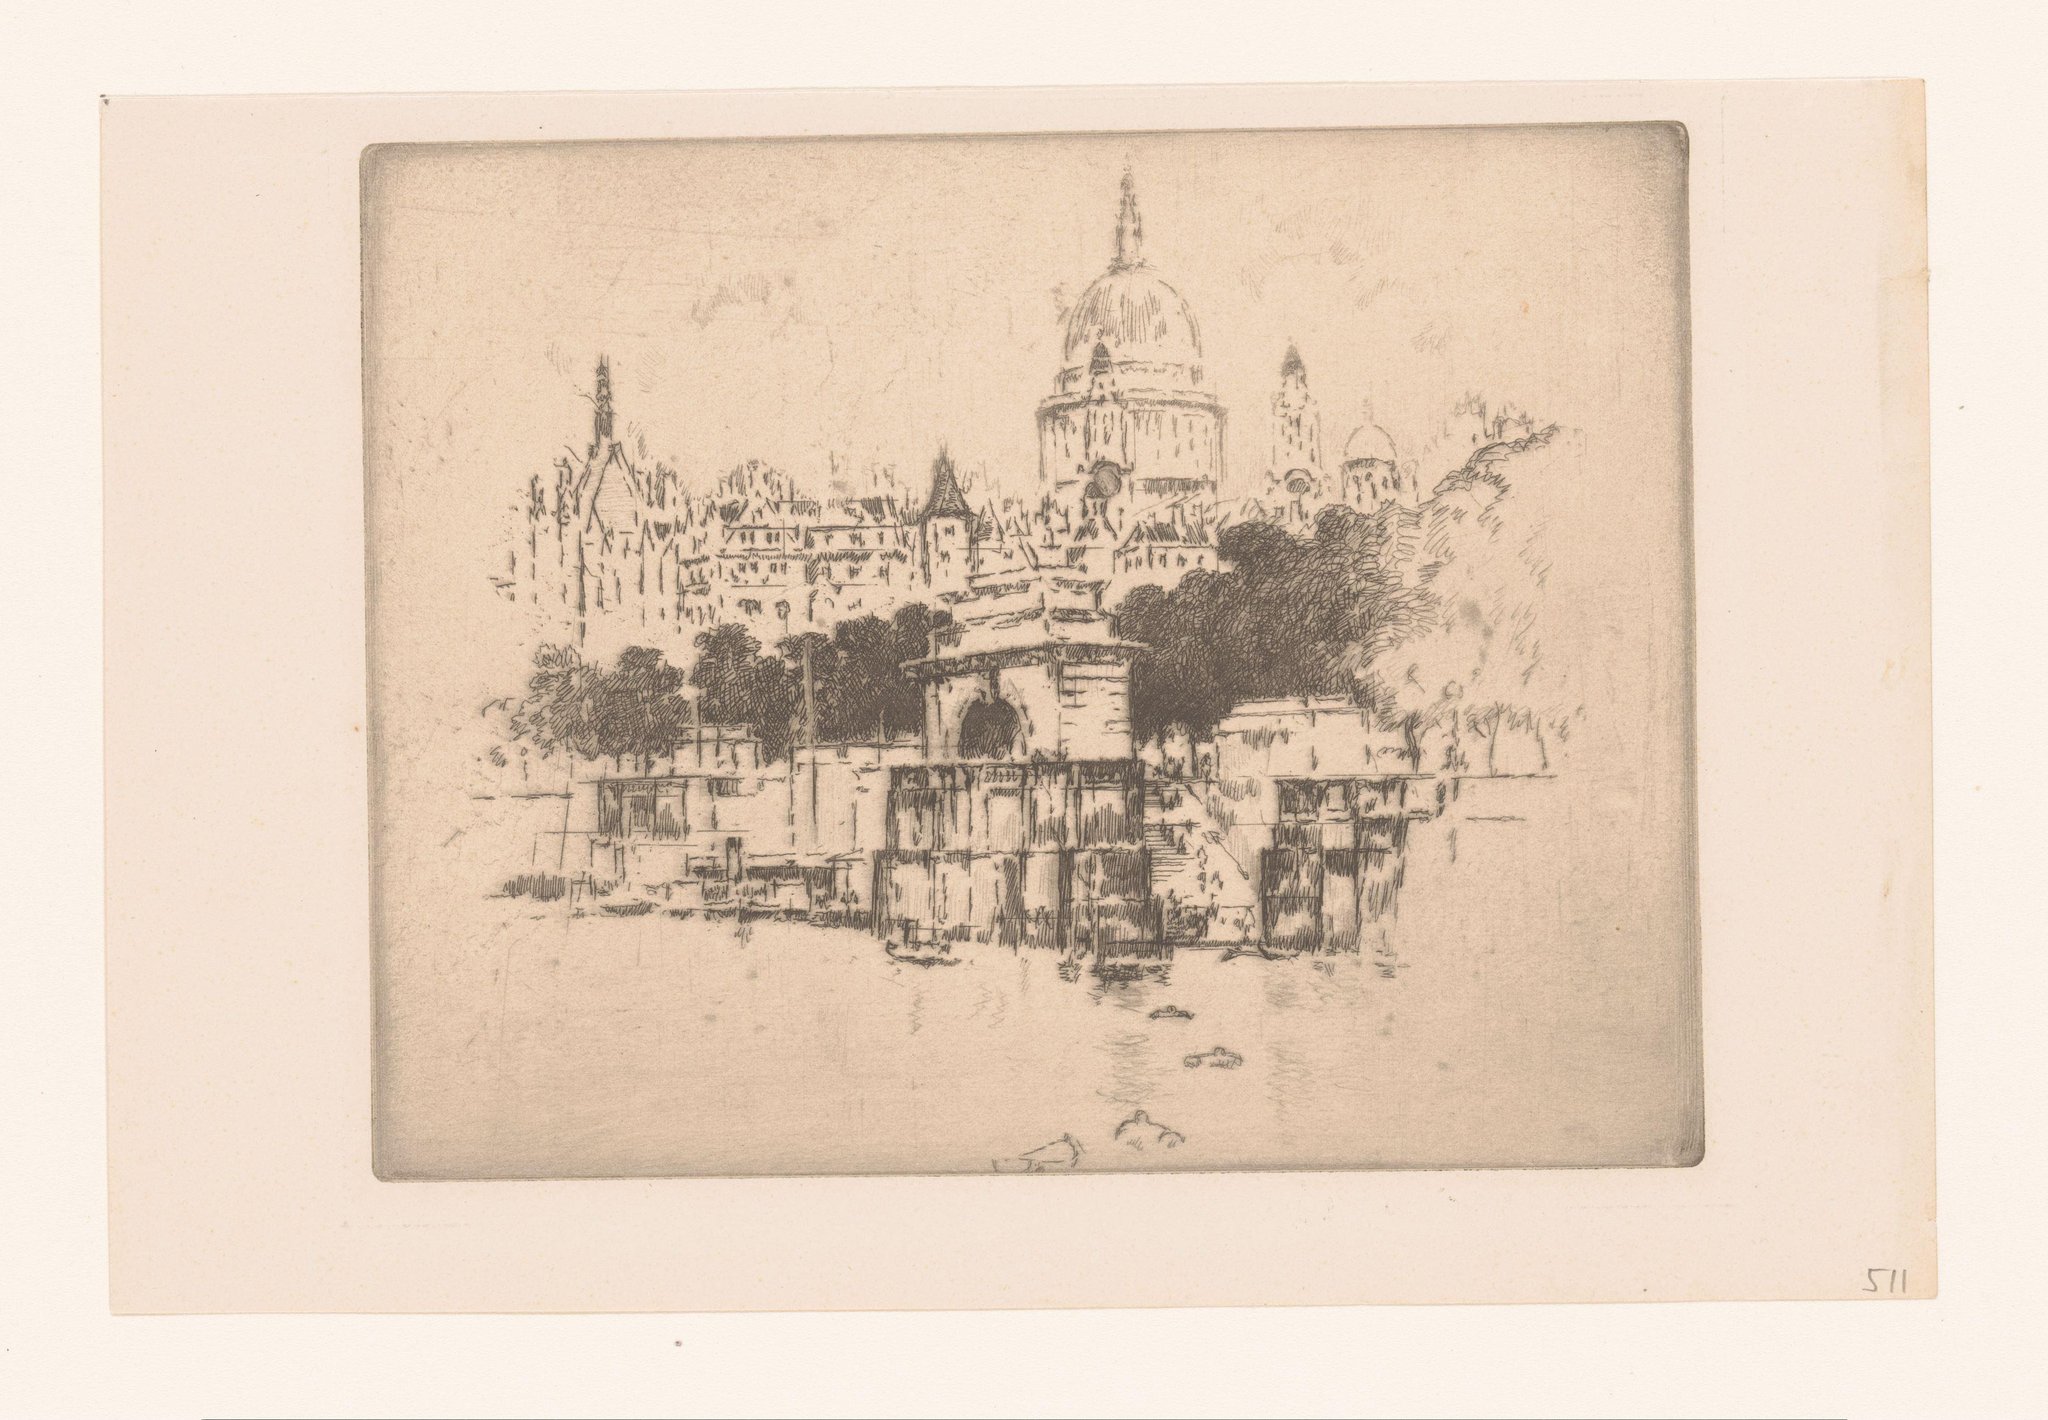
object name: print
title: St Paul's over Temple Stairs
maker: joseph pennell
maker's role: print maker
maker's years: 1857-1926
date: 1905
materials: paper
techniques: etching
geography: united states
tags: church (exterior), city-view in general; 'veduta' (+ city(-scape) with figures, staffage)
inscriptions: collector's mark: Lugt 2228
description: St Paul's gezien van de rivier, met trappen die naar het water leiden.